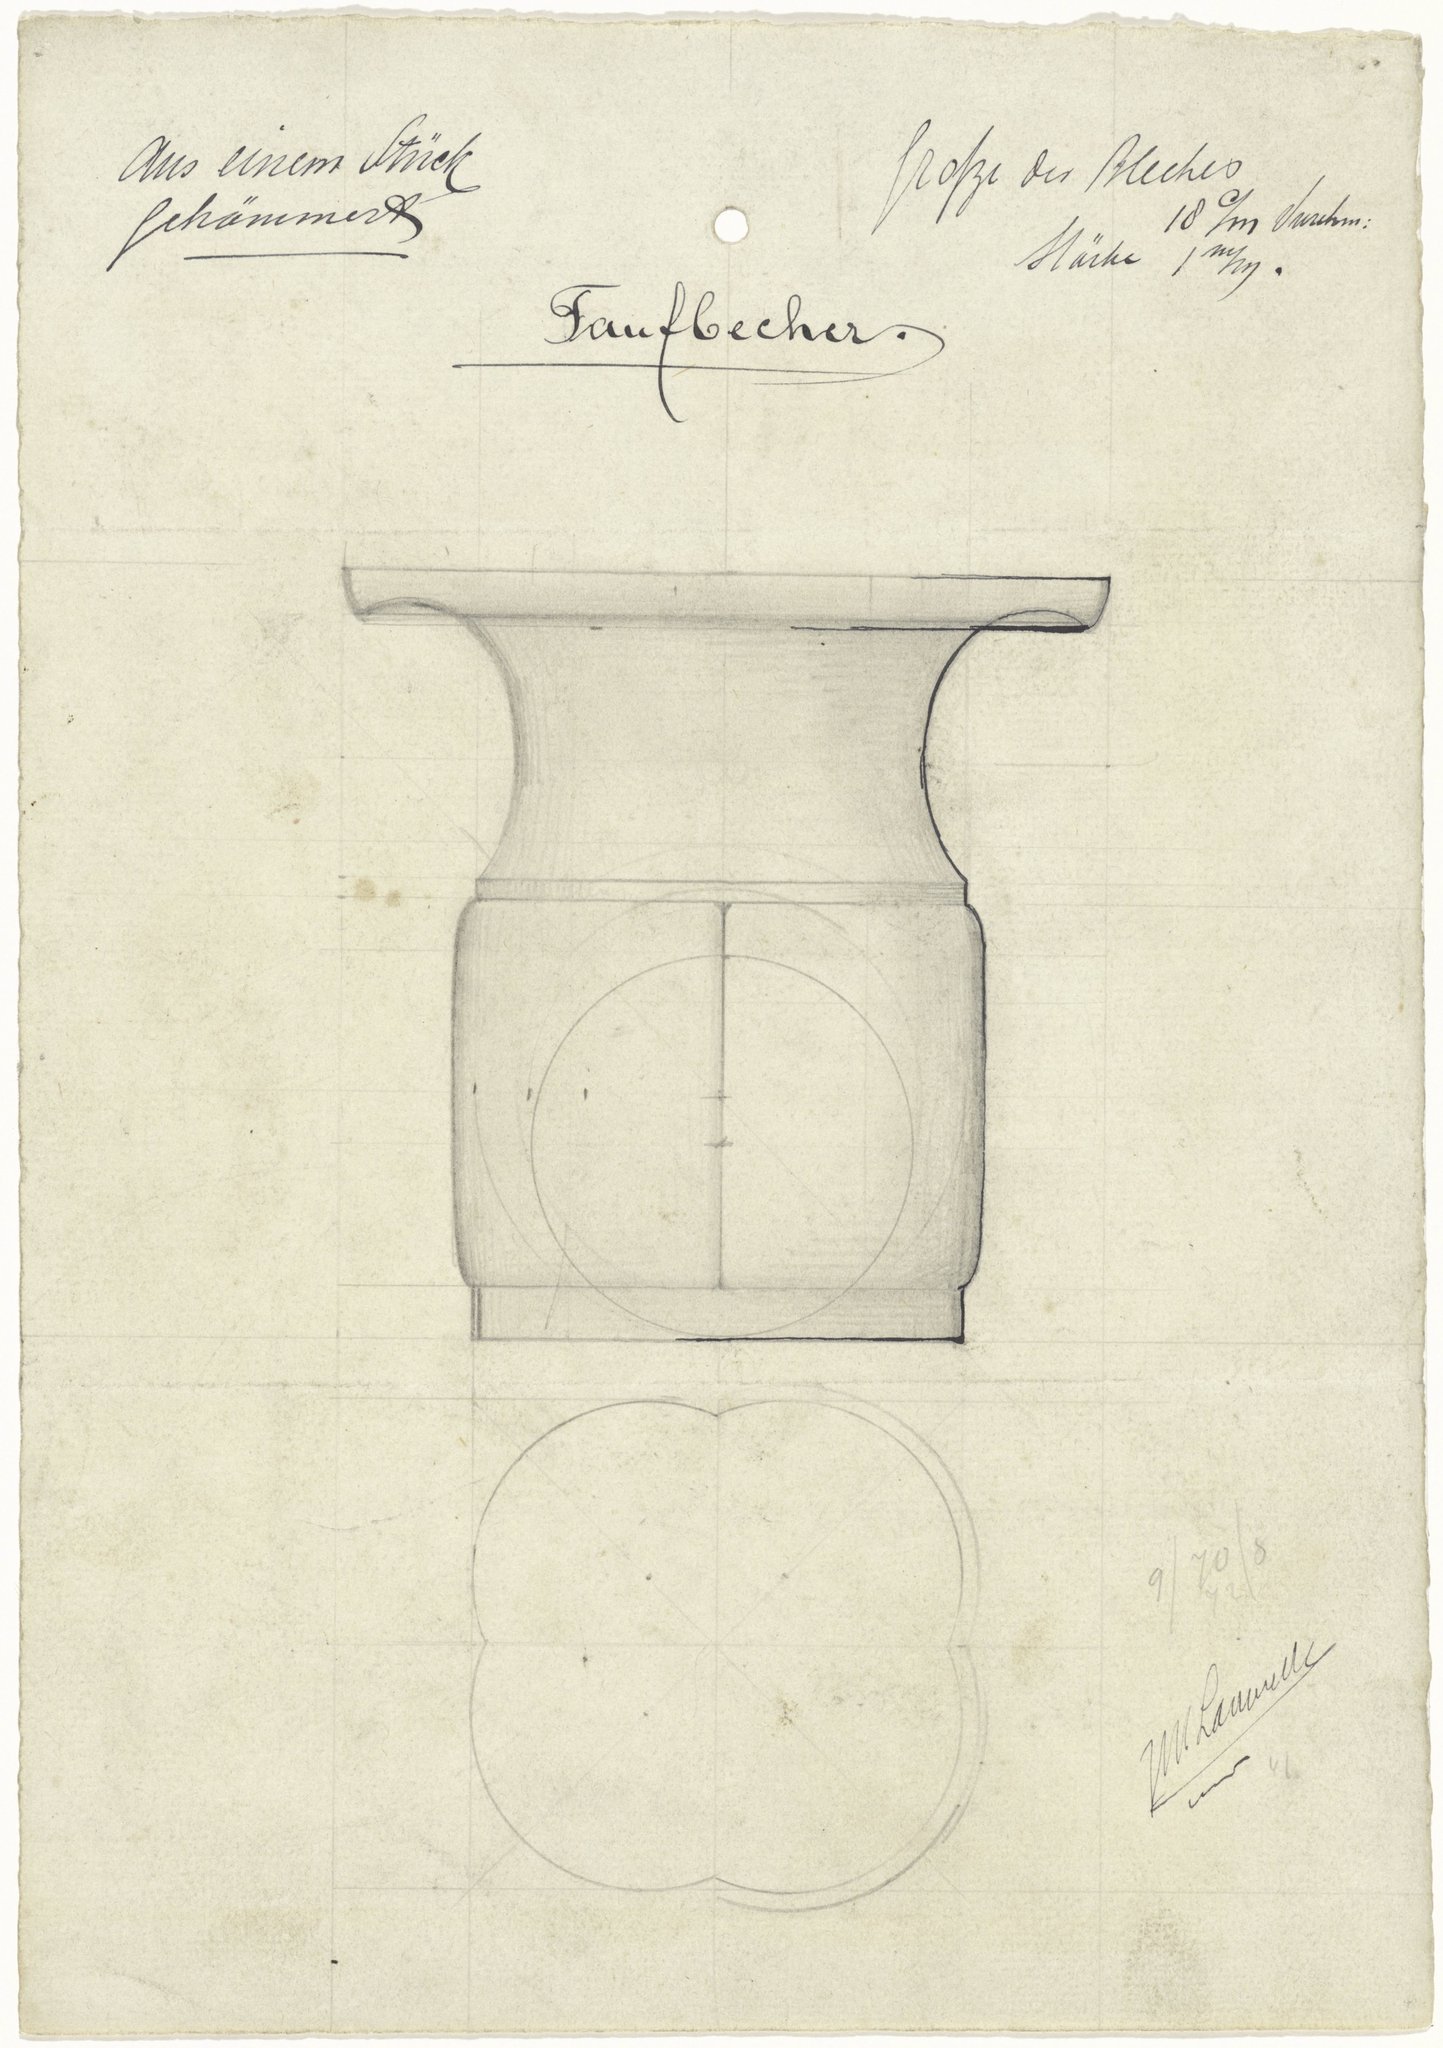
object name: design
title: Ontwerp voor een doopbeker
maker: mathieu lauweriks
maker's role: designer, draughtsman, print maker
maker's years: 1864-1932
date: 1874-1932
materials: ink, paper, pencil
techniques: pen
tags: other utensils used in the church (baptismal cup)